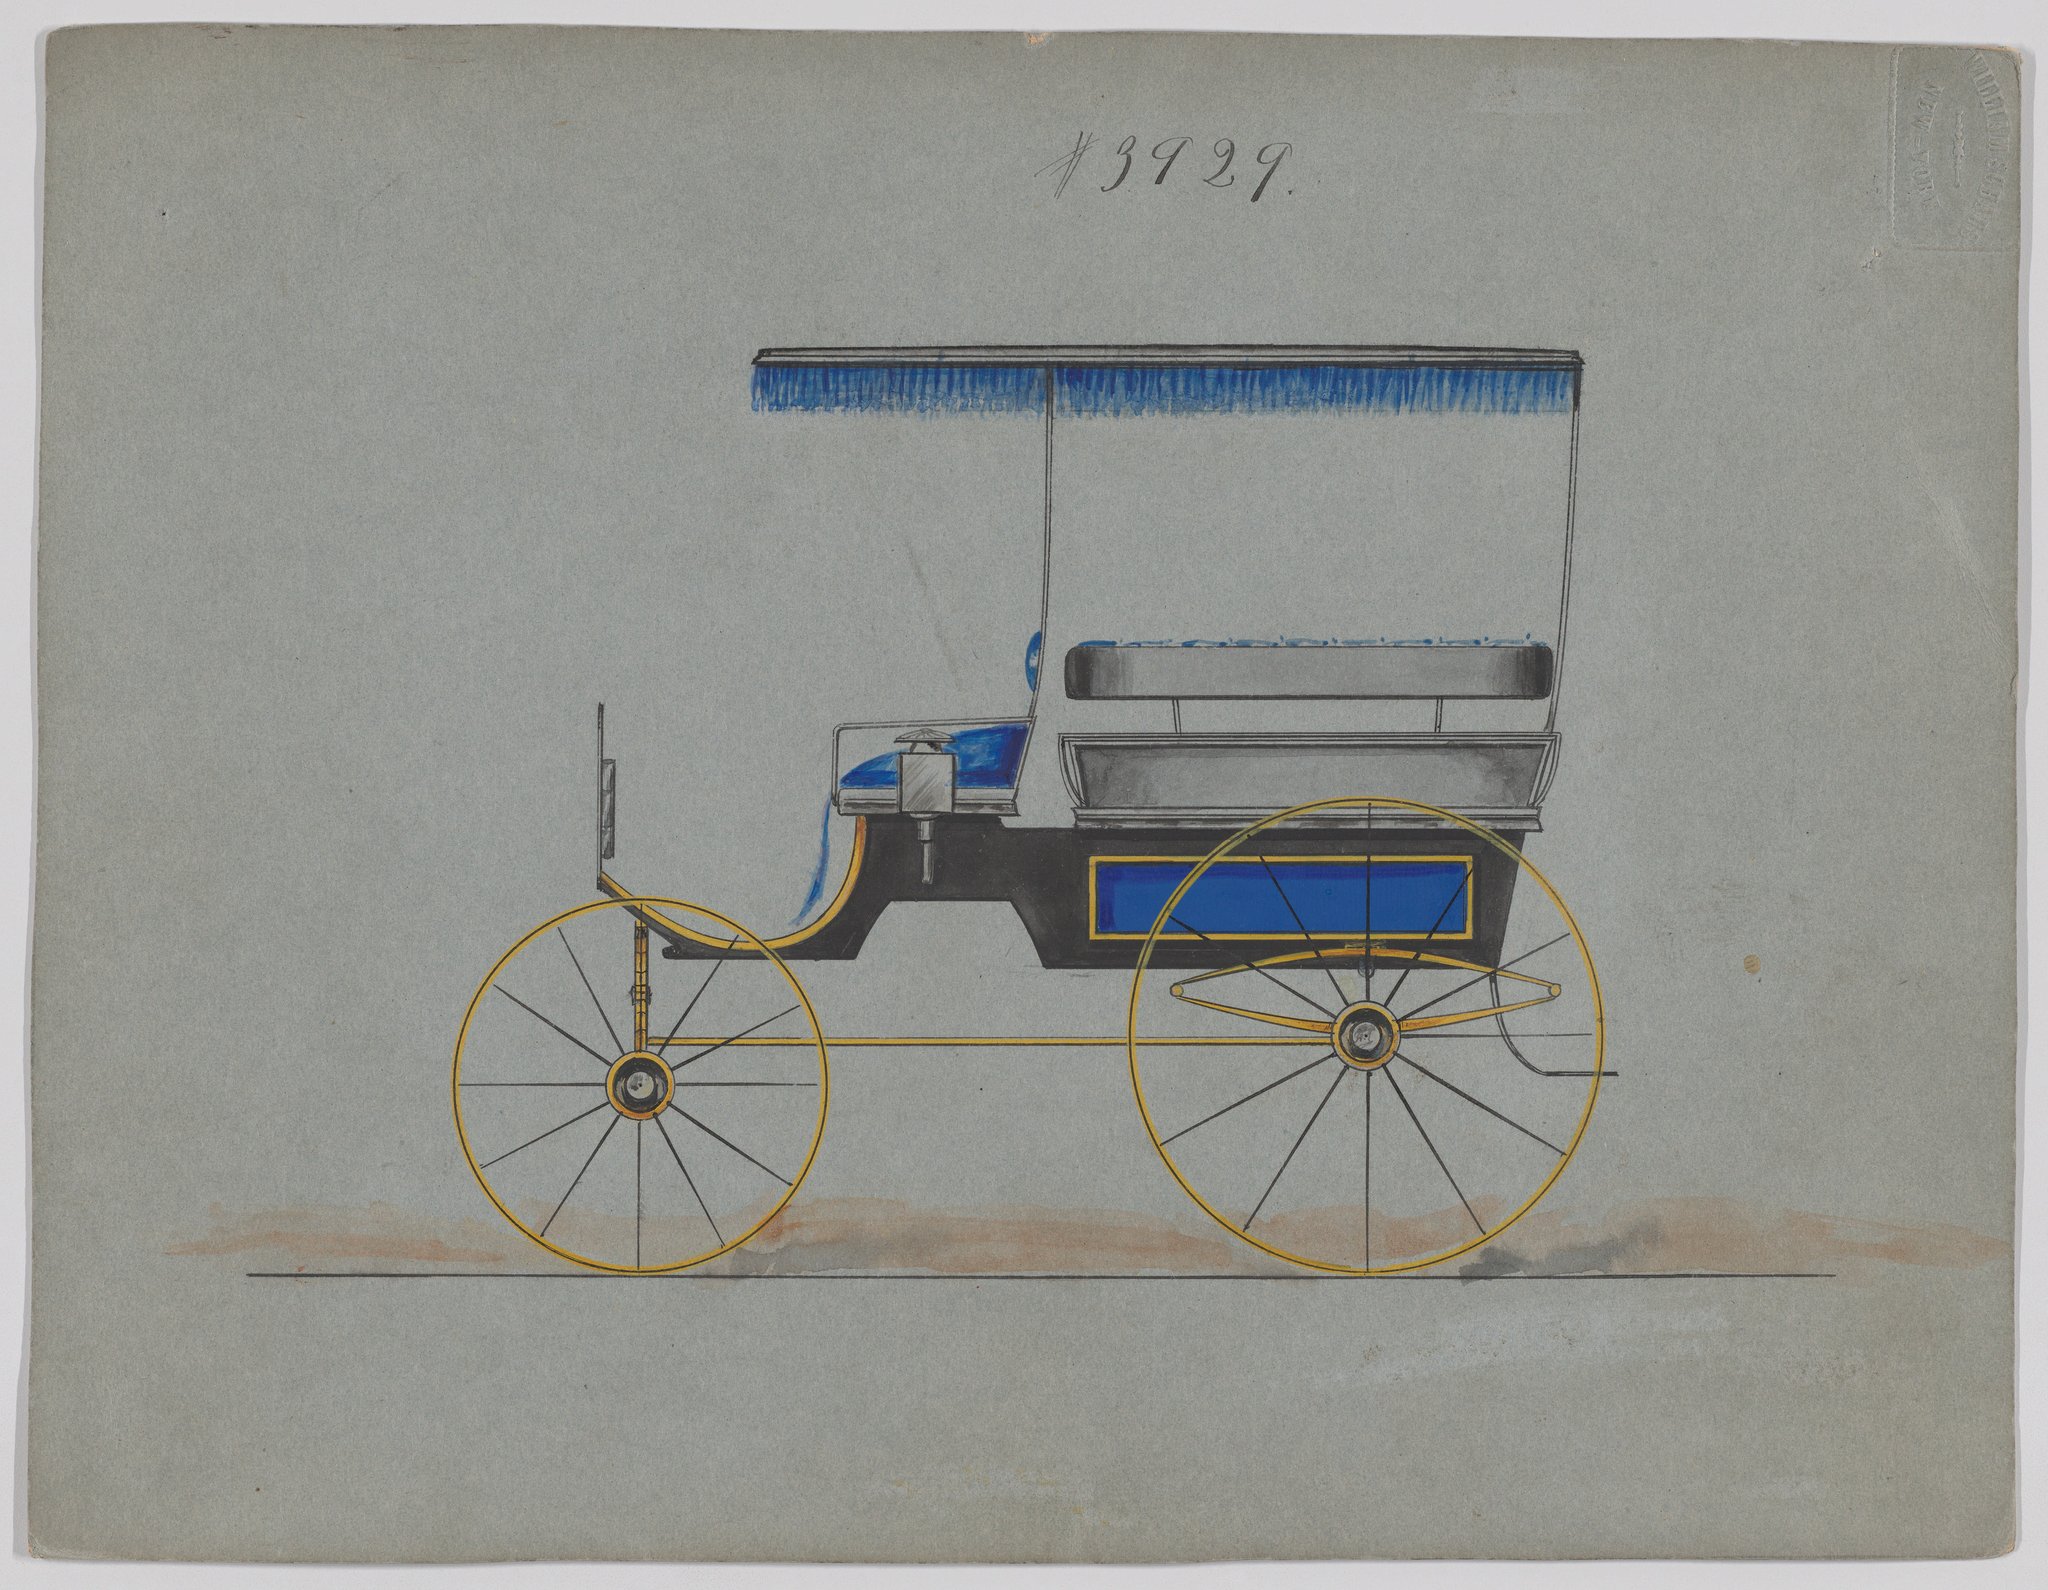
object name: drawing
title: Design for Omnibus or Wagonette, no. 3929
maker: brewster & co.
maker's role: manufacturer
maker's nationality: american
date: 1884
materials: ink, watercolor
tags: carriages